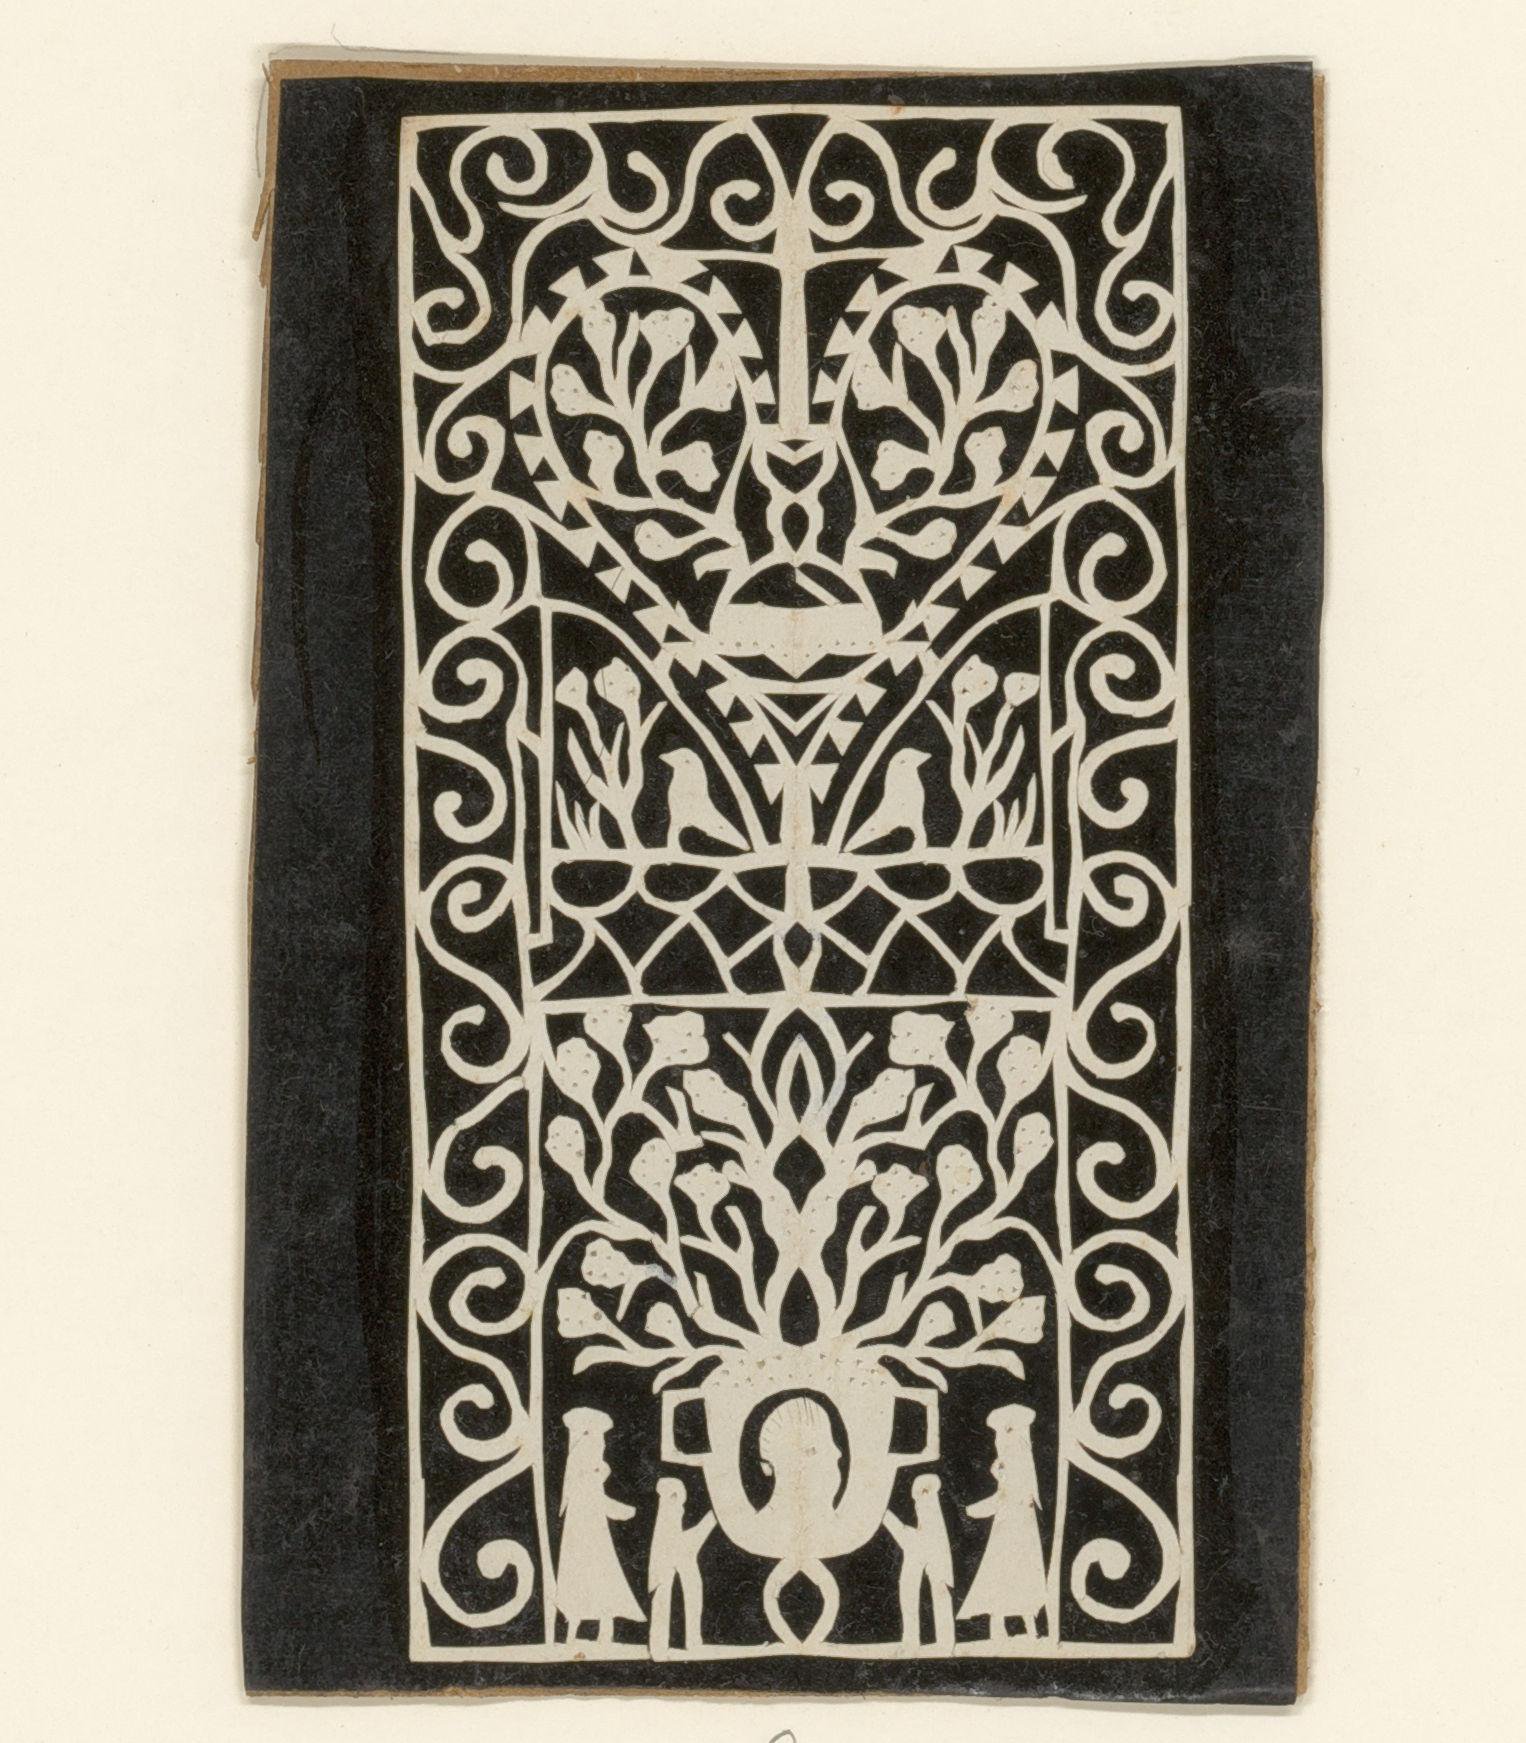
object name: cut paper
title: Knipsels met een hart en figuren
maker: Anonymous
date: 1750-1849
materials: paper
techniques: cutting, snipping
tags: standing figure, heart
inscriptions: stamp, collector's mark: Lugt 1641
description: Drie symetrische knipkunstwerken tegen elkaar aan op één blad geplakt met grote harten met initialen, links PKDJK, in het midden JKD en rechts KJL. Onder en boven de harten o.a. engeltjes met bazuinen, menselijke figuurtjes, vogels en huisjes. Onderwerpsrubrieken binnen de Atlas Zeden en Gewoonten: Schoone kunsten, Knipkunst.